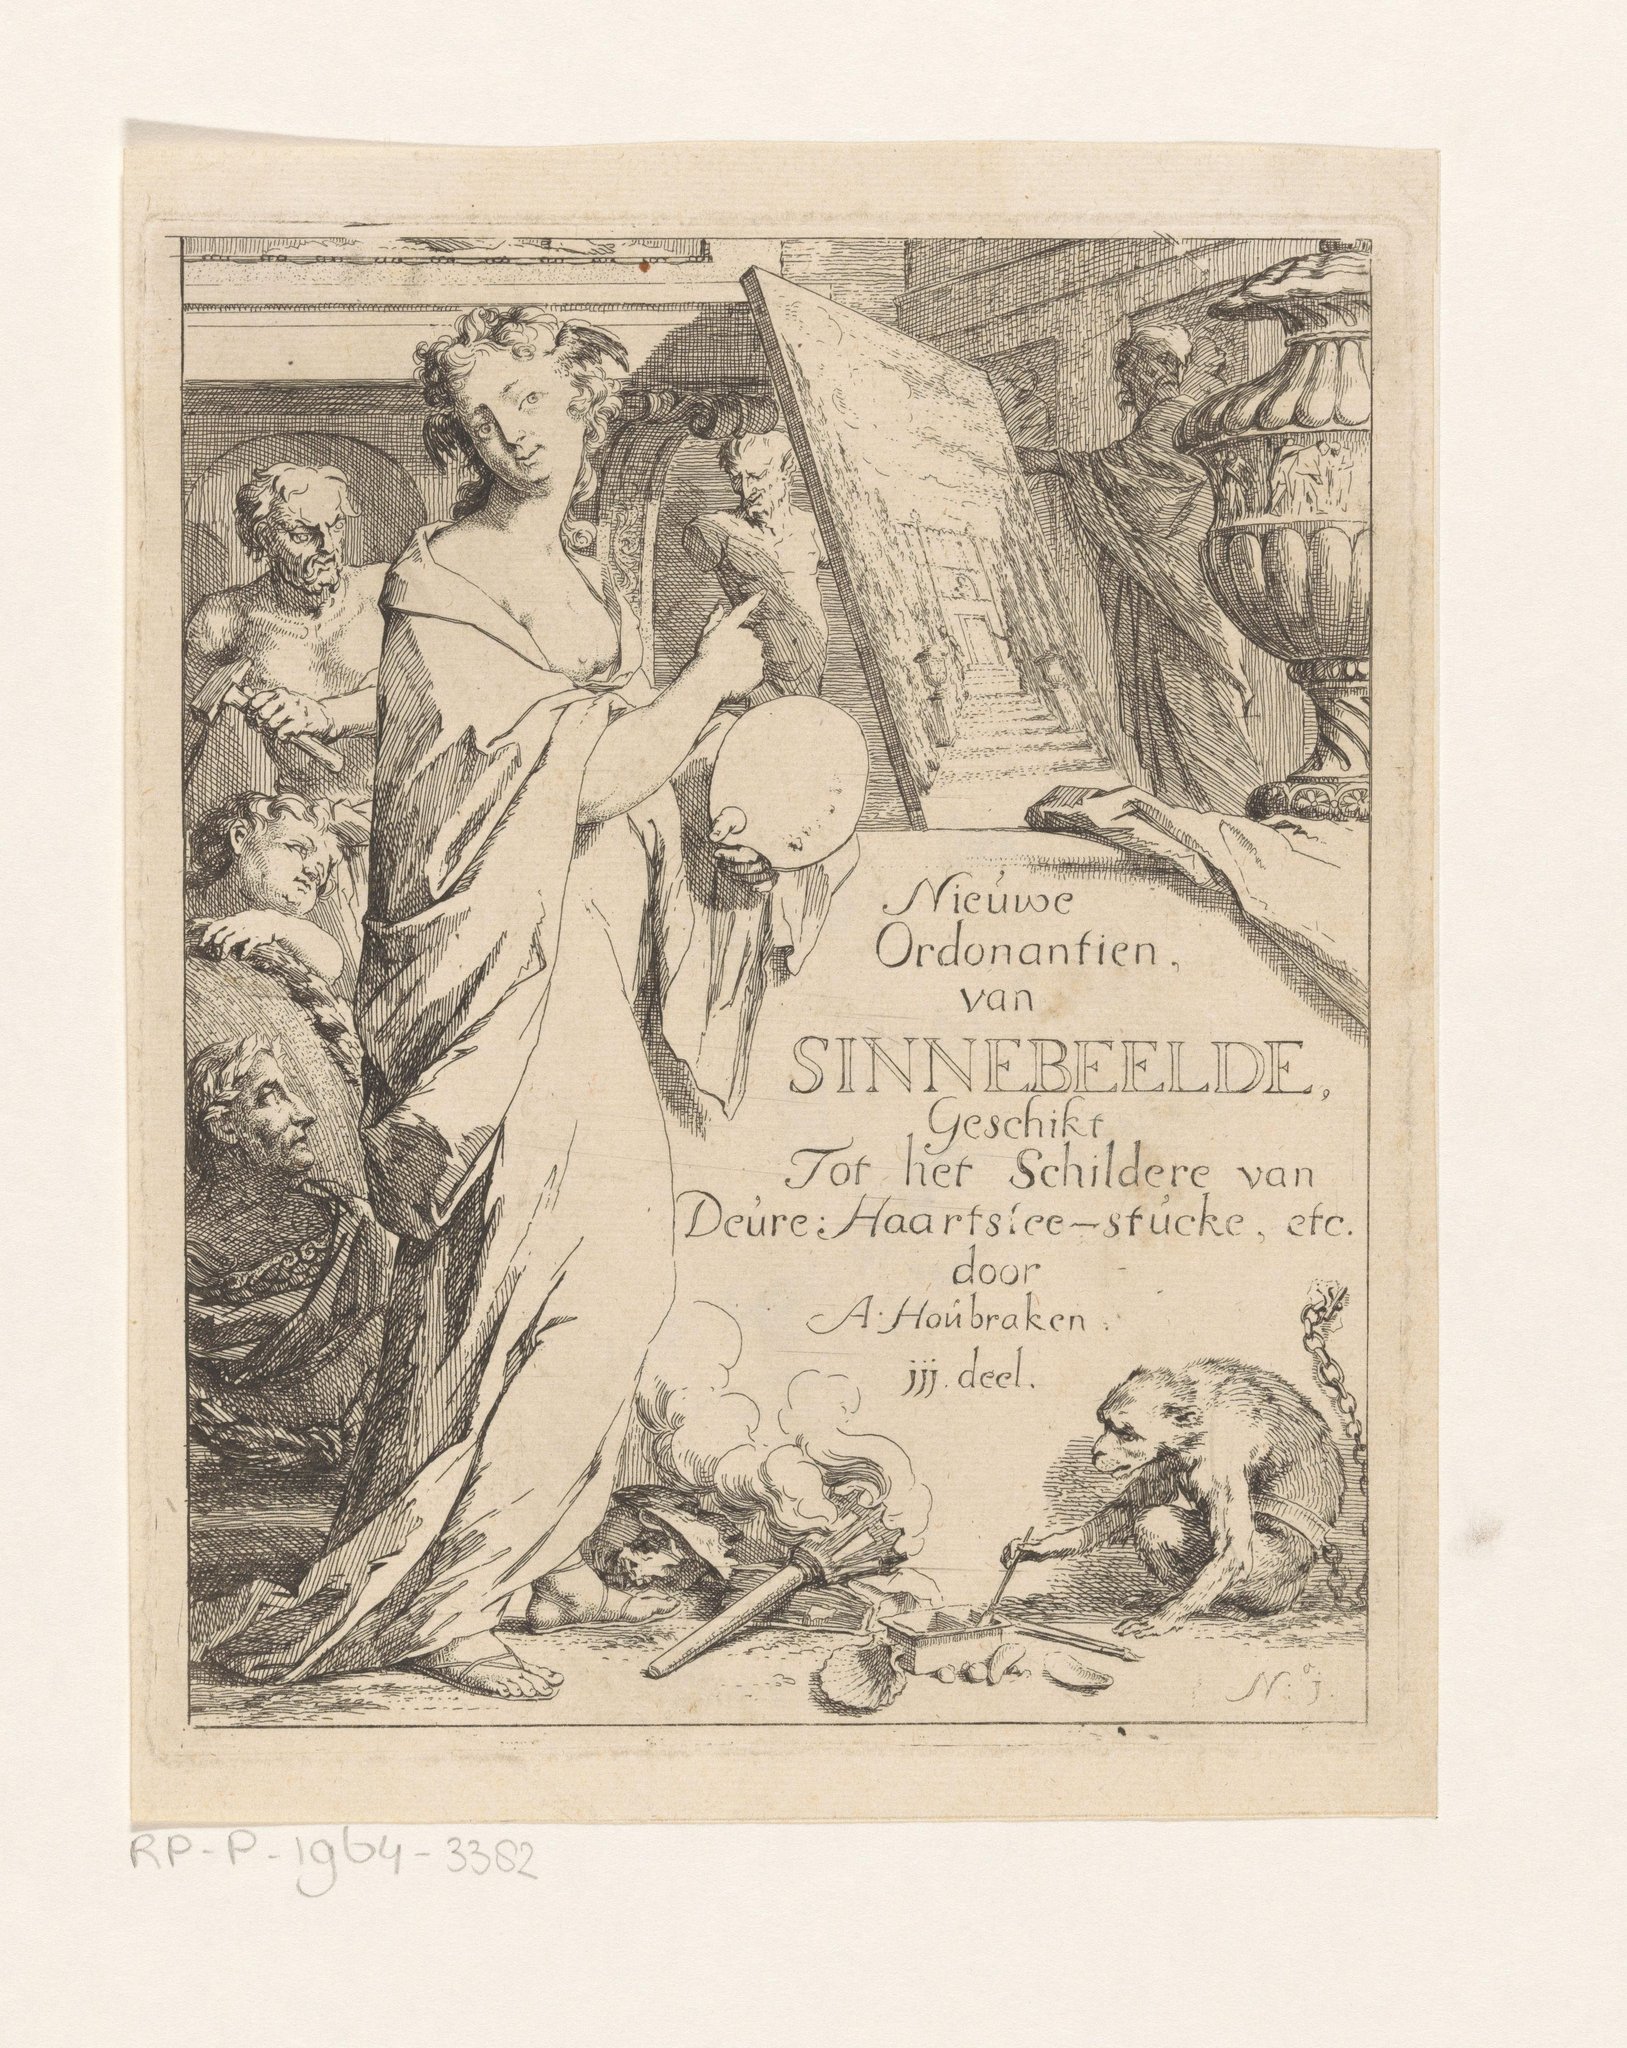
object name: print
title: Vrouwfiguur met palet wijzend op een schilderij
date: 1700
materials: paper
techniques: etching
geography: dordrecht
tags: palette, picture, painting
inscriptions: collector's mark: Lugt 2228, collector's mark: Lugt 2760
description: Een vrouwfiguur met een schilderspalet in haar linkerhand wijst op een schilderij. Links op de achtergrond een figuur met een hamer en een putto met een portretmedaillon. Rechts naast haar de serietitel. Daaronder een vastgeketende aap met een penseel in zijn hand en op de grond onder andere een brandende fakkel. Rechts onder No. 3.